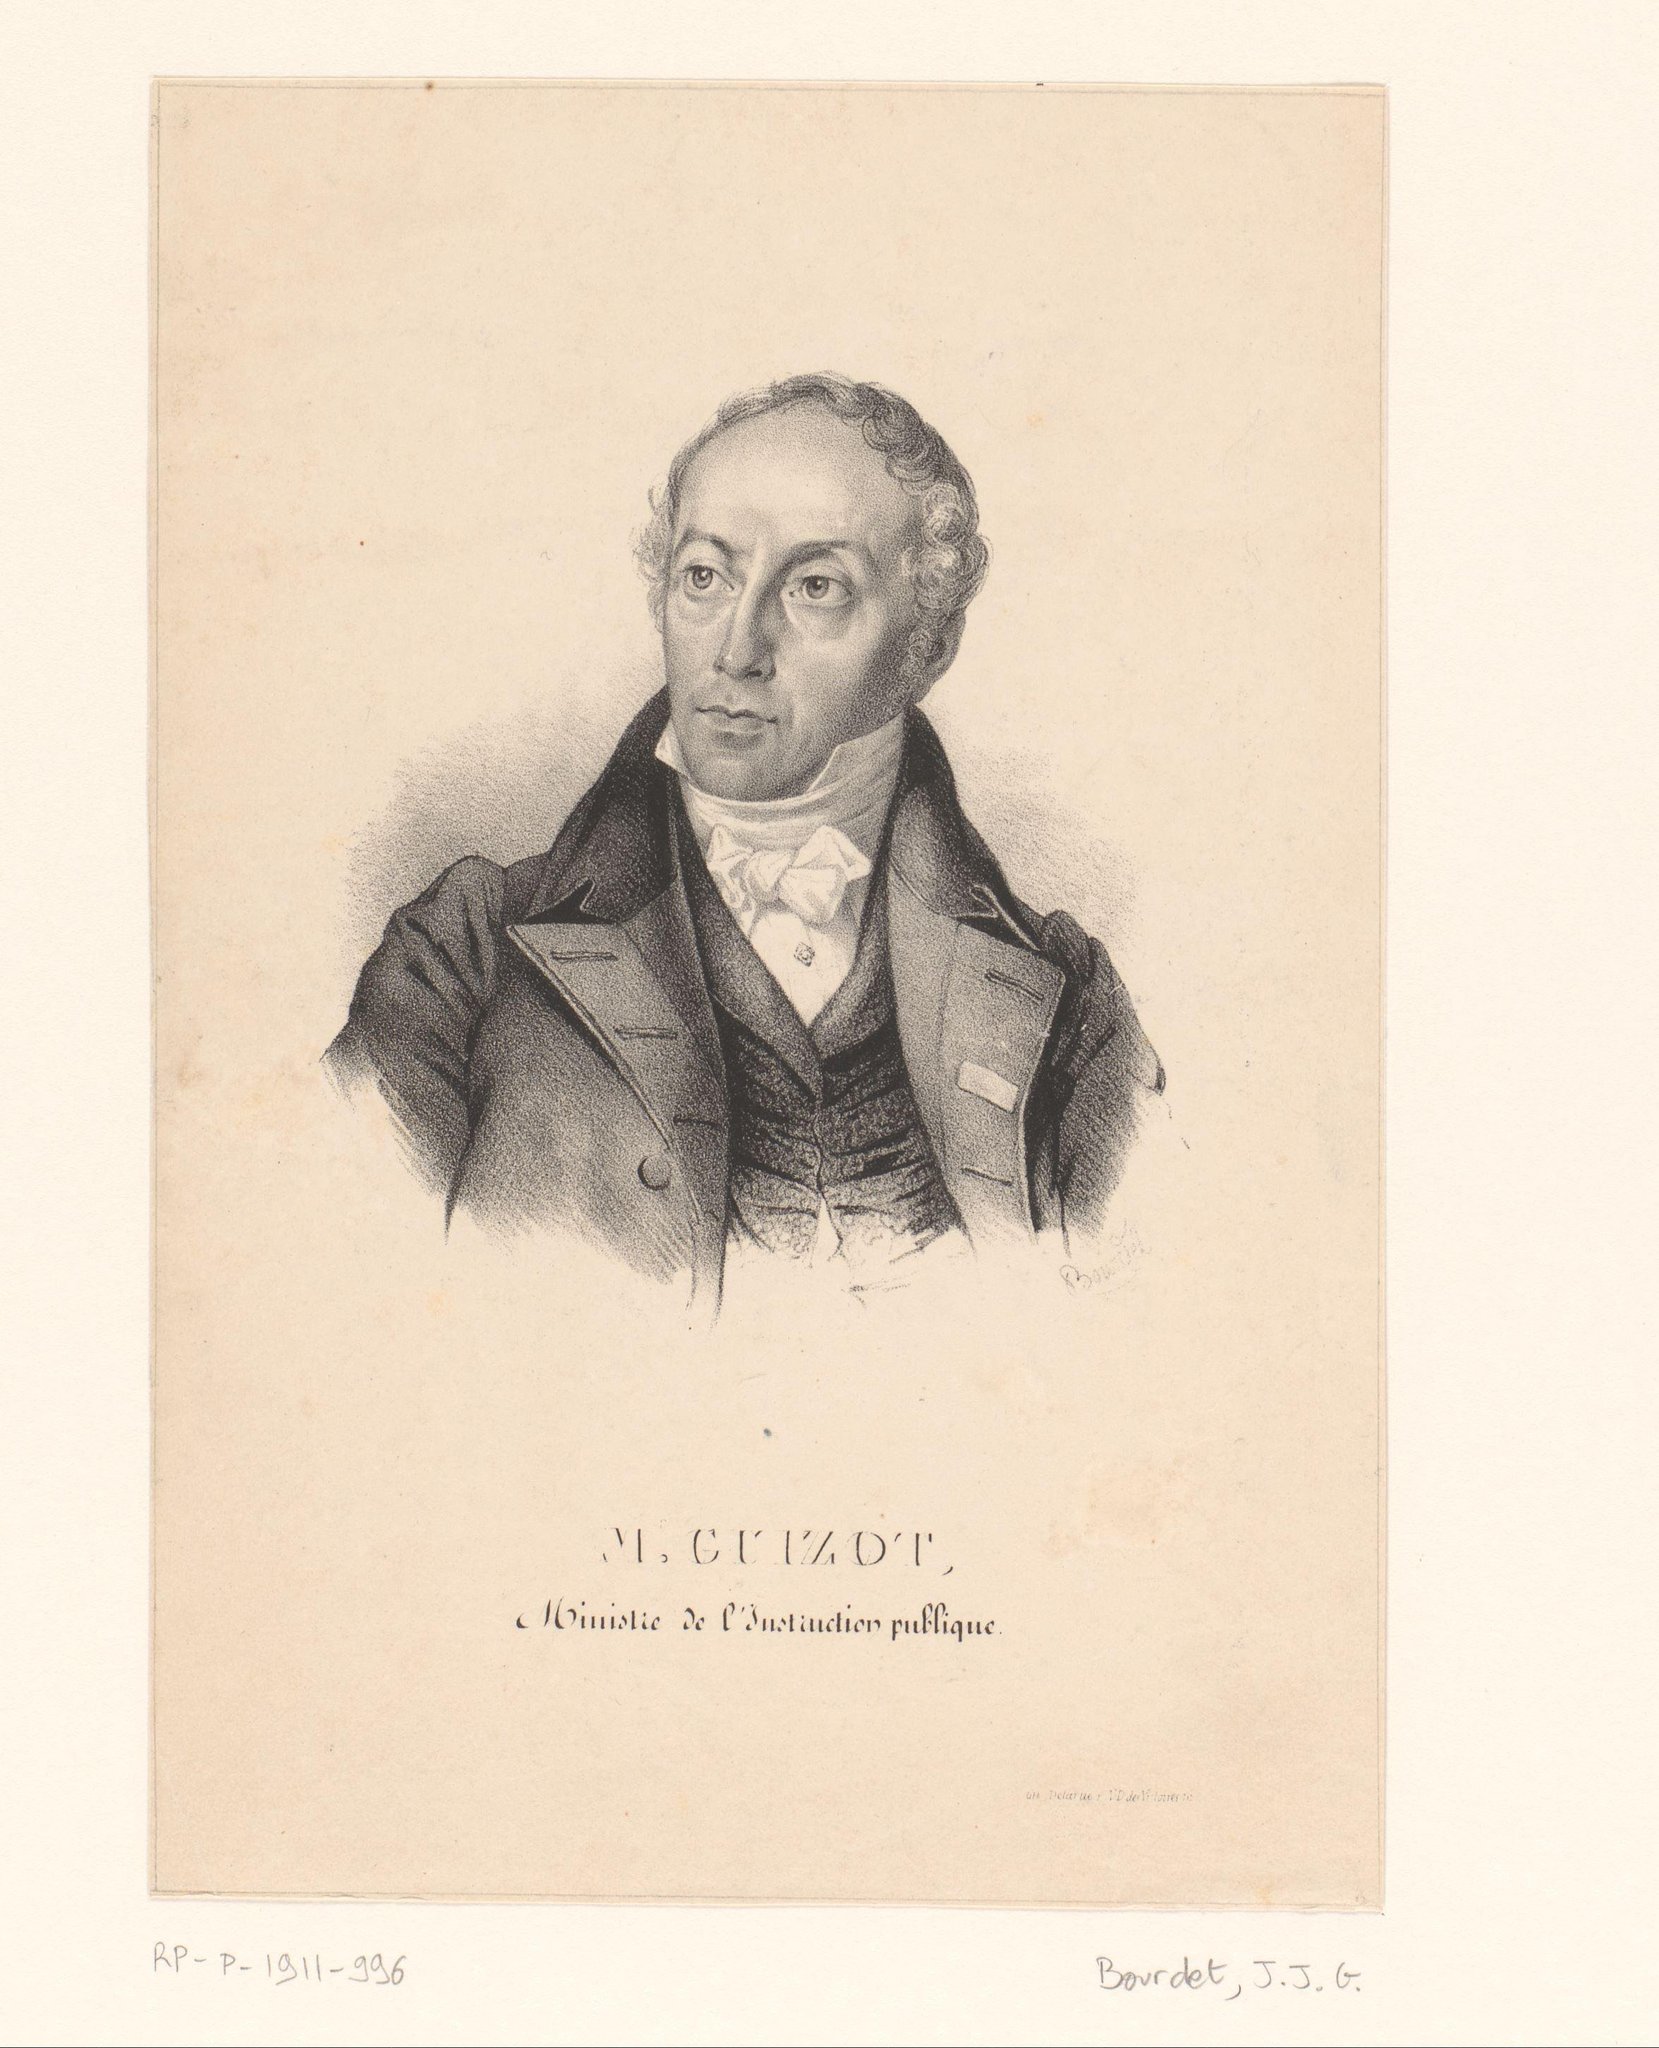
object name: print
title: M. Guizot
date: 1836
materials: paper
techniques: lithograph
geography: paris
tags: historical persons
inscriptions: collector's mark: Lugt 2228a